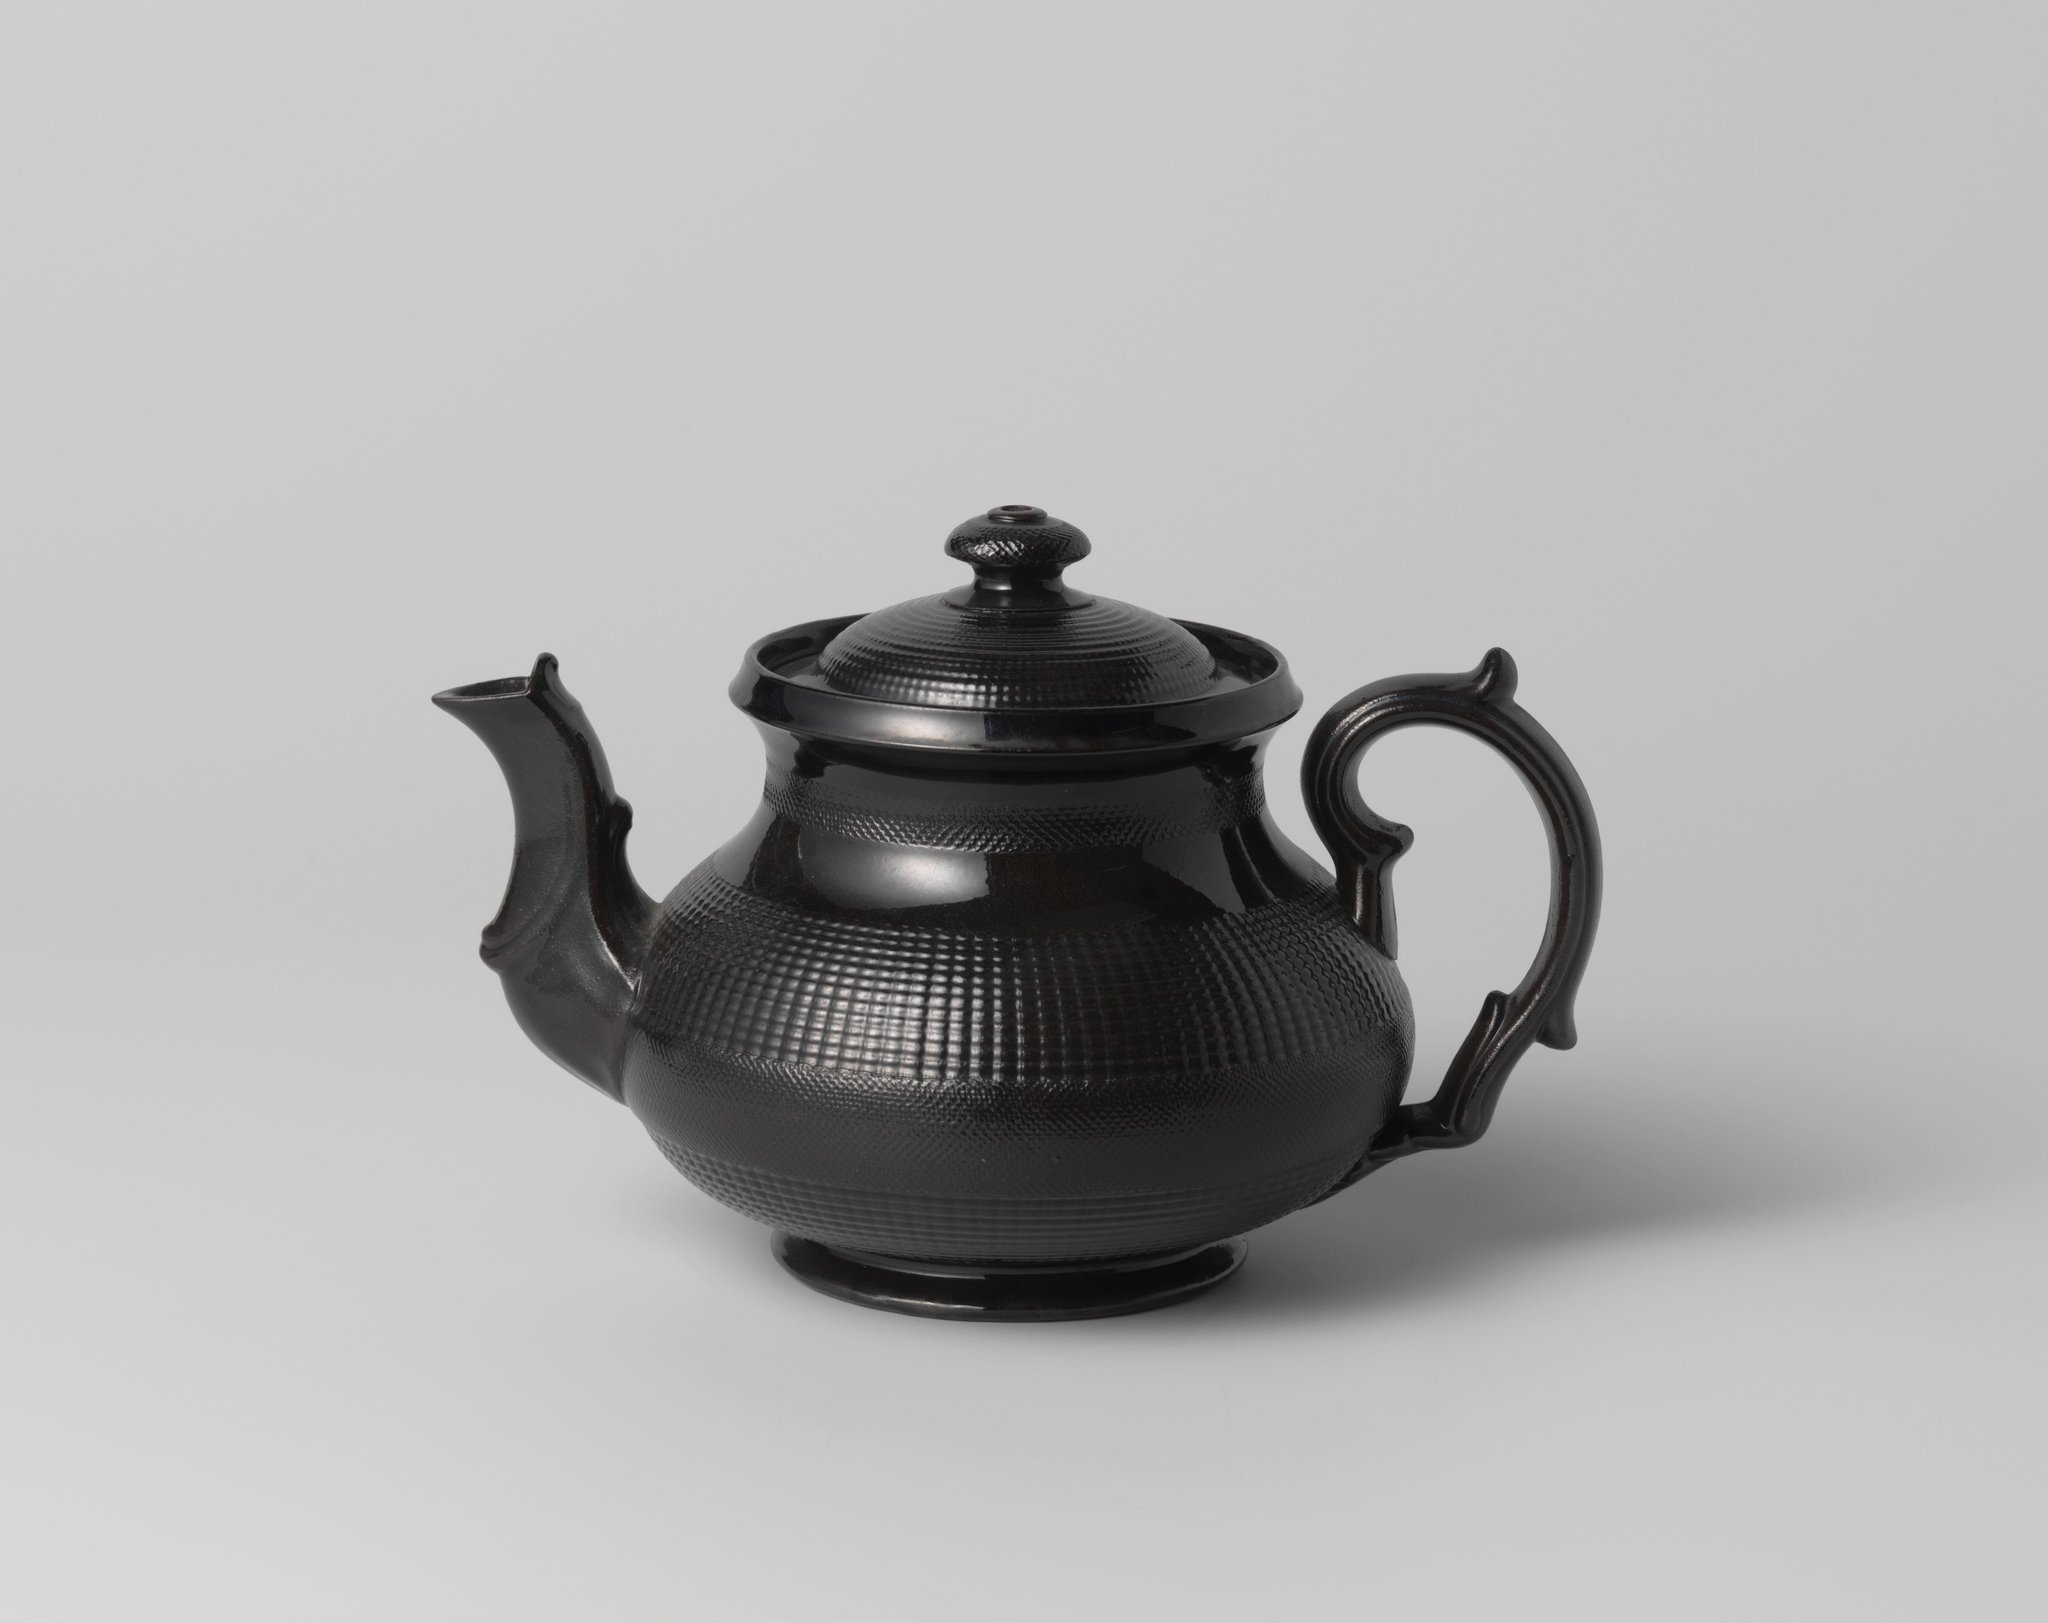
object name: teapot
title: Deksel, zwart, gedecoreerd met ribbelranden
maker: petrus regout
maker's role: plateelbakker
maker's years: 1801-1879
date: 1860-1880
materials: stoneware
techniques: engels steengoed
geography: maastricht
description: Deksel van zwartsteen. Het deksel is gedecoreerd met dicht op elkaar gelegen concentrische ribbelranden, en heeft een ronde knop met luchtgat.